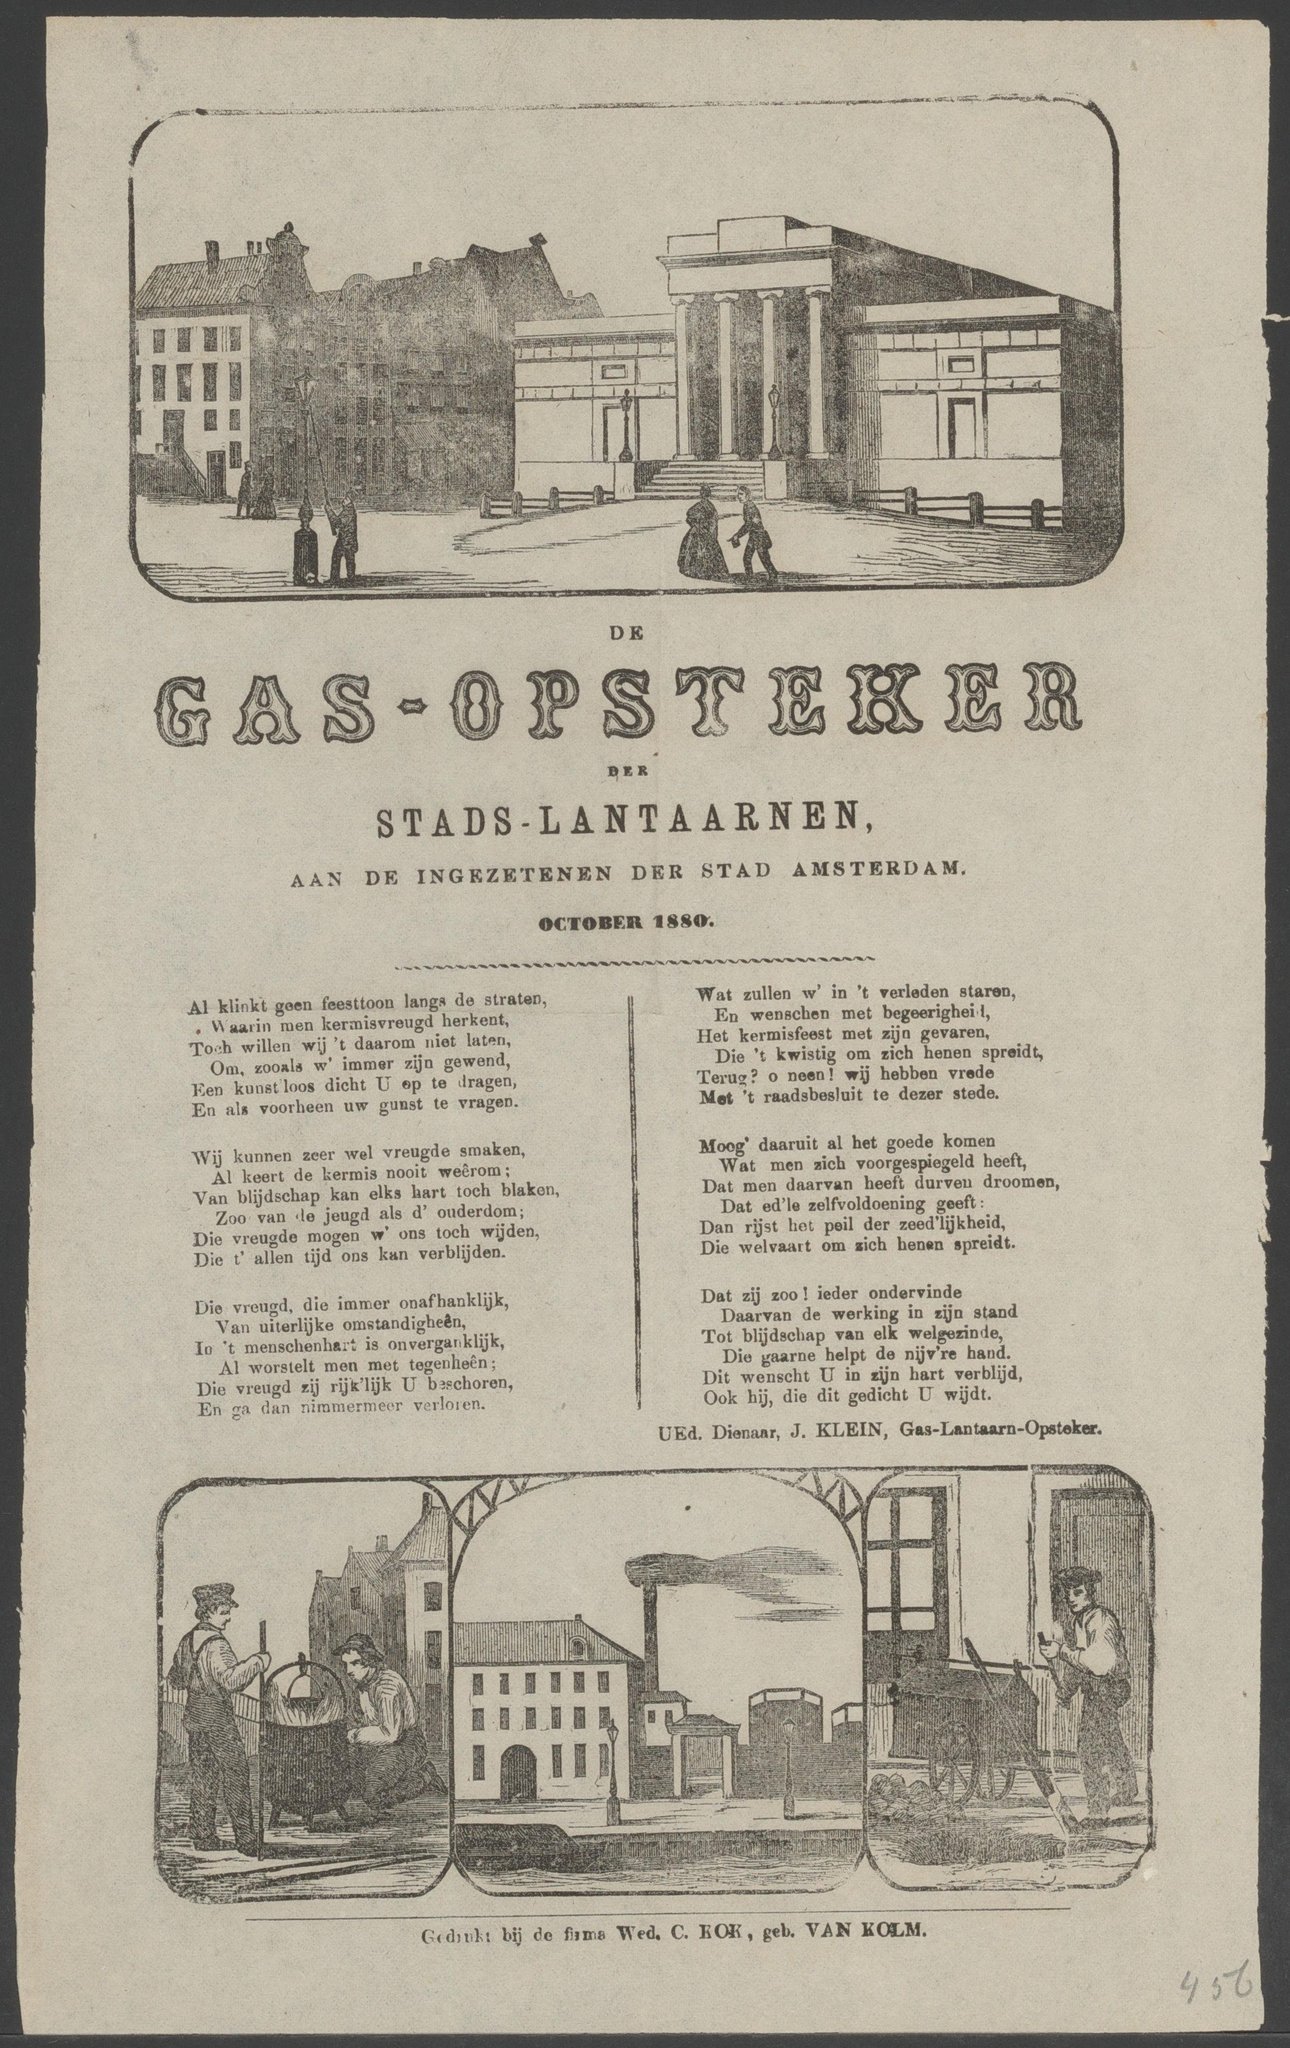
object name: print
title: De Gas-opsteker der stads-lantaarnen, aan de ingezetenen der stad Amsterdam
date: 1880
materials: paper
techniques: letterpress printing, engraving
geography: amsterdam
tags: gas-lamp, gas supply, digging (industrial process), street lighting, amsterdam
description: Kermiswens van de Amsterdamse gaslantaarnopstekers voor het jaar 1880. Centraal een vers in twee kolommen. Bovenaan de Dam met de beurs van Zocher te Amsterdam. Onderaan de Hollandsche Gasfabriek en twee gasfitters aan het werk. Van de gaslantaarnopsteker: J. Klein. Onderwerpsrubrieken binnen de Atlas Zeden en Gewoonten: Zeden en gewoonten in engeren zin, Volksleven, Volksbladen, Nieuwjaars- en Kerstwenschen, Amsterdam.